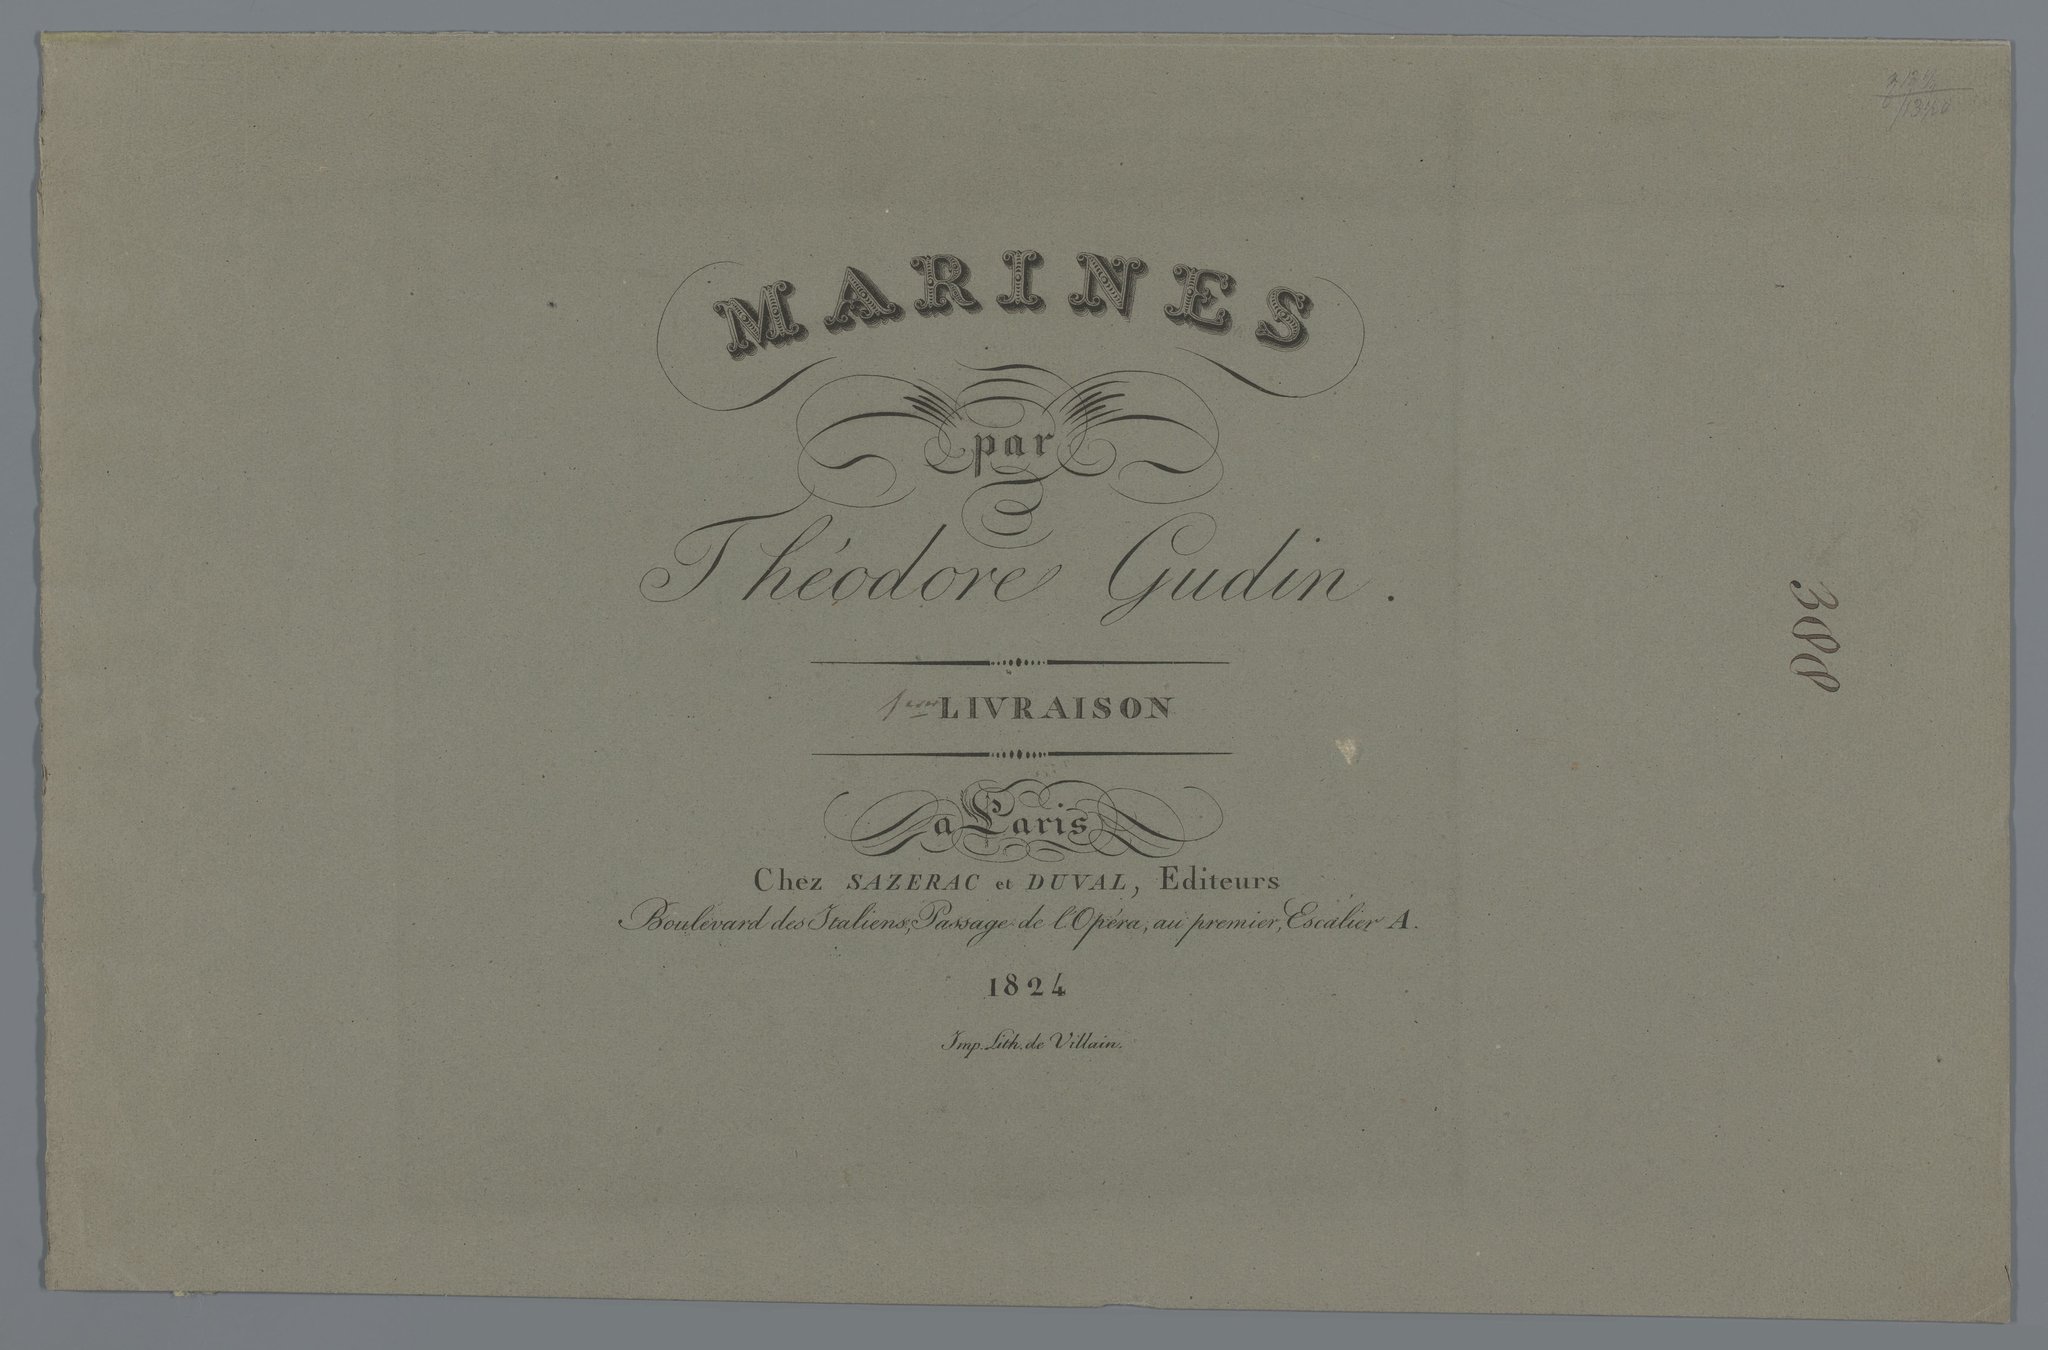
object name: wrapper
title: Marines par Théodore Gudin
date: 1824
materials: paper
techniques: lithograph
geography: paris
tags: writing and letters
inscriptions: date